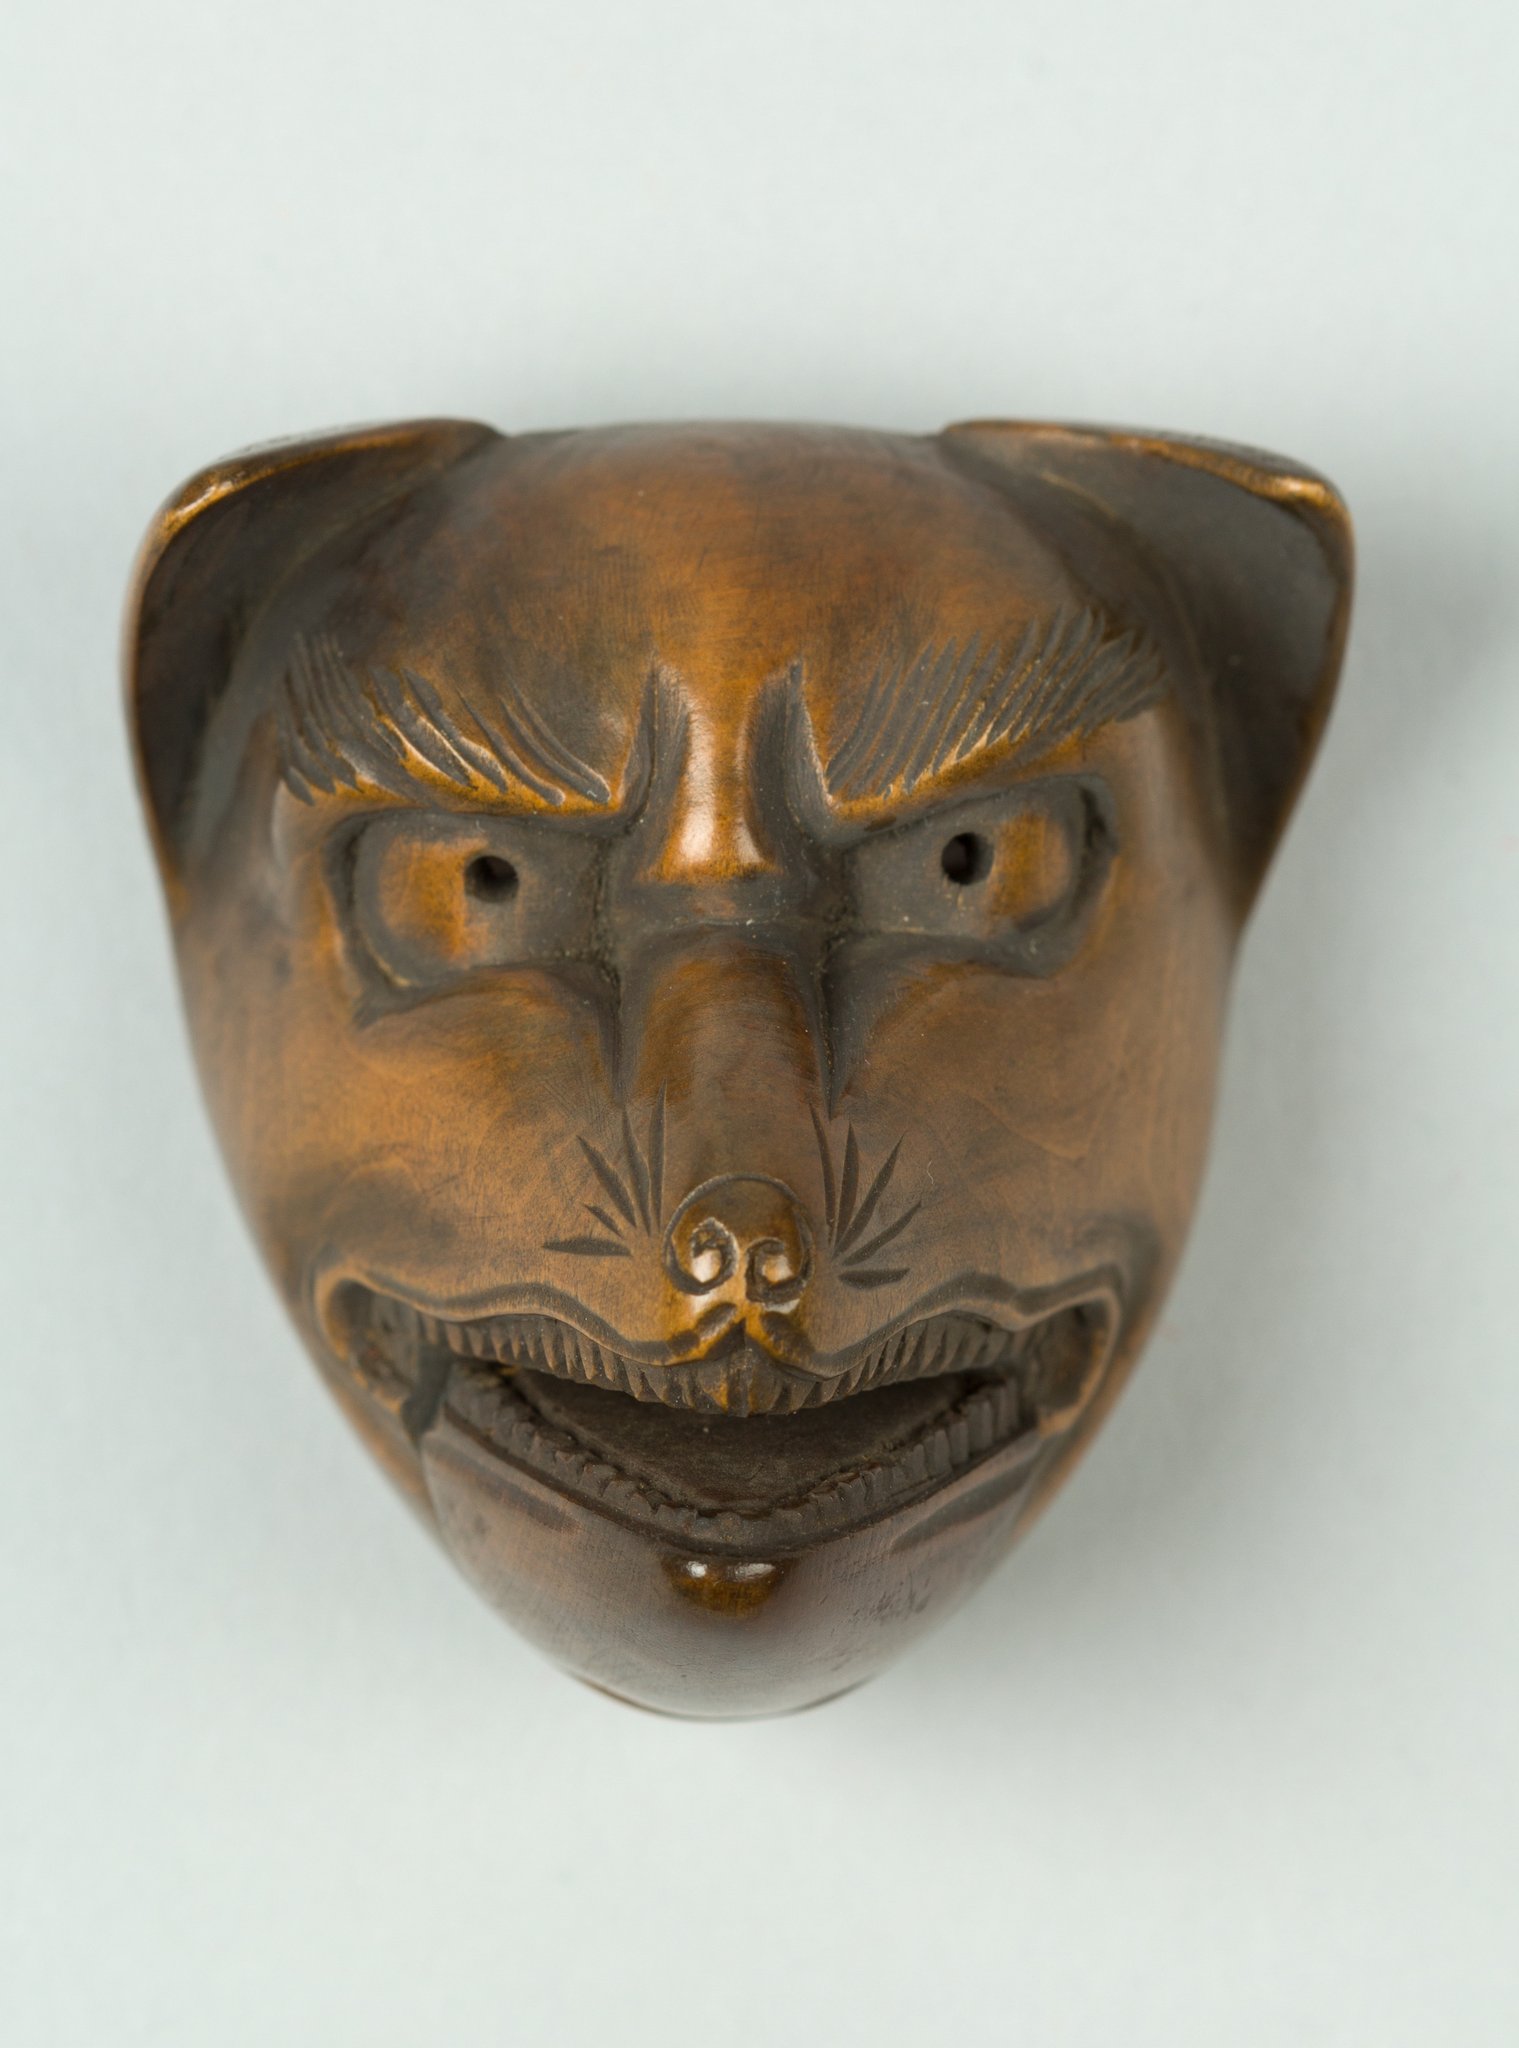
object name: netsuke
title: Netsuke of Animal Face Mask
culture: japanese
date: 1801-1900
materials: wood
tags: animals,masks,faces